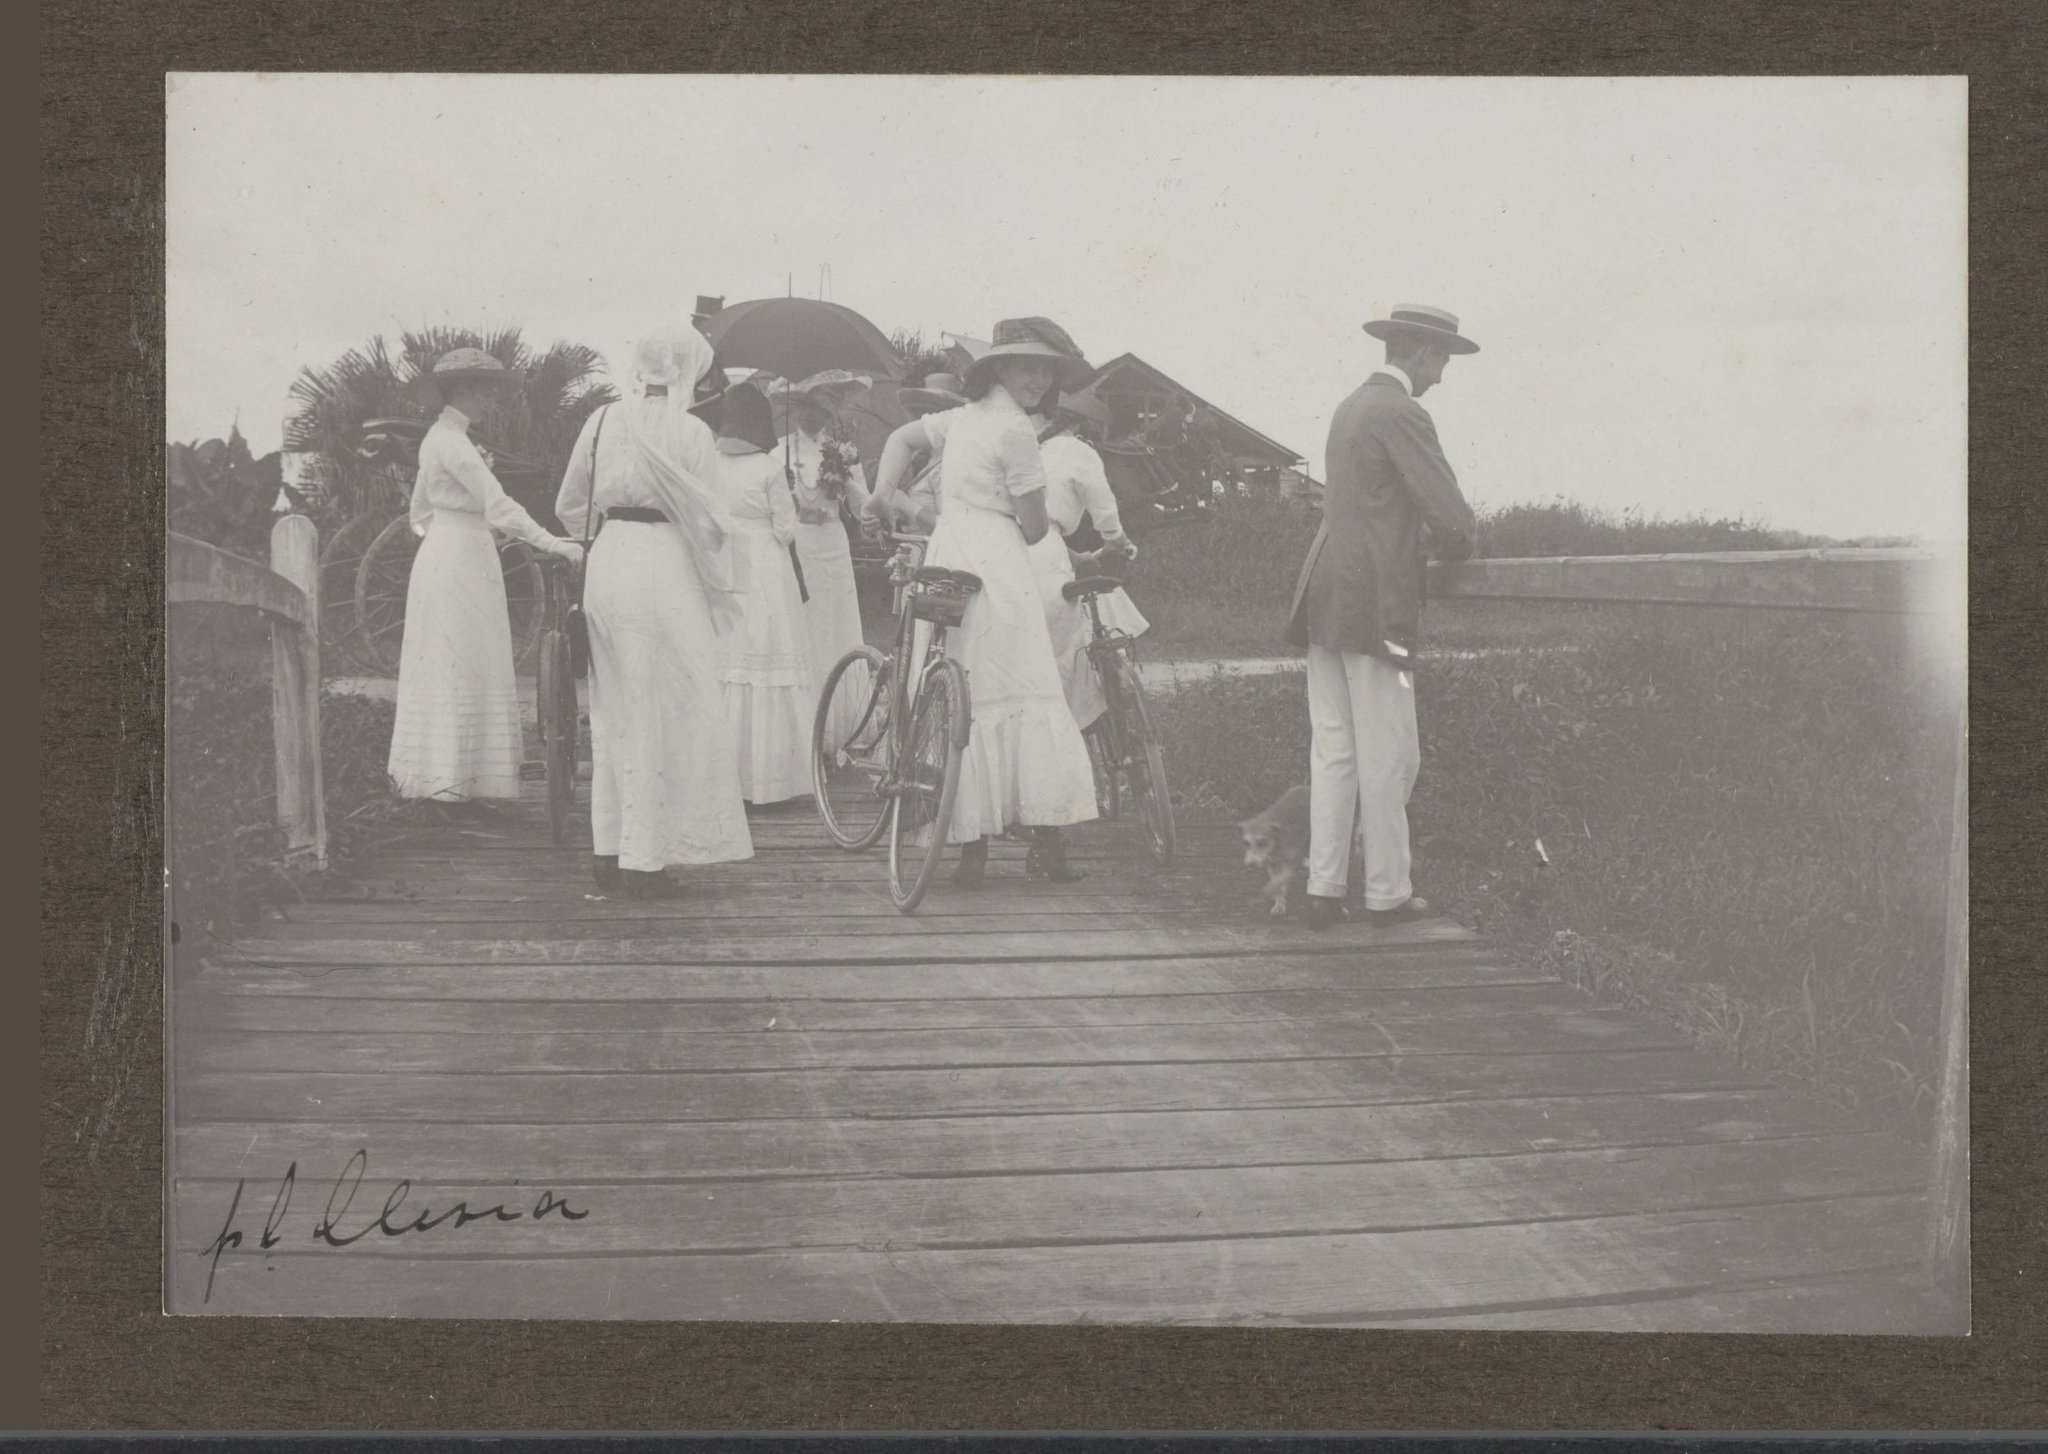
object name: photograph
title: Verschillende leden van de familie Gonggrijp en vrienden op plantage Clevia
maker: Anonymous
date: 1910-1914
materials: photographic support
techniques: photography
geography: suriname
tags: plantation, suriname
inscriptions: inscription: ‘pl Clevia’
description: Verschillende leden van de familie Gonggrijp met vrienden op plantage Clevia. De vrouwen allemaal in wit, enkelen met parasol en fiets, rechts een man bij de brugleuning. Onderdeel van een groep van elf albumbladen met familiefoto's van de familie Gonggrijp in Suriname, ca. 1912.